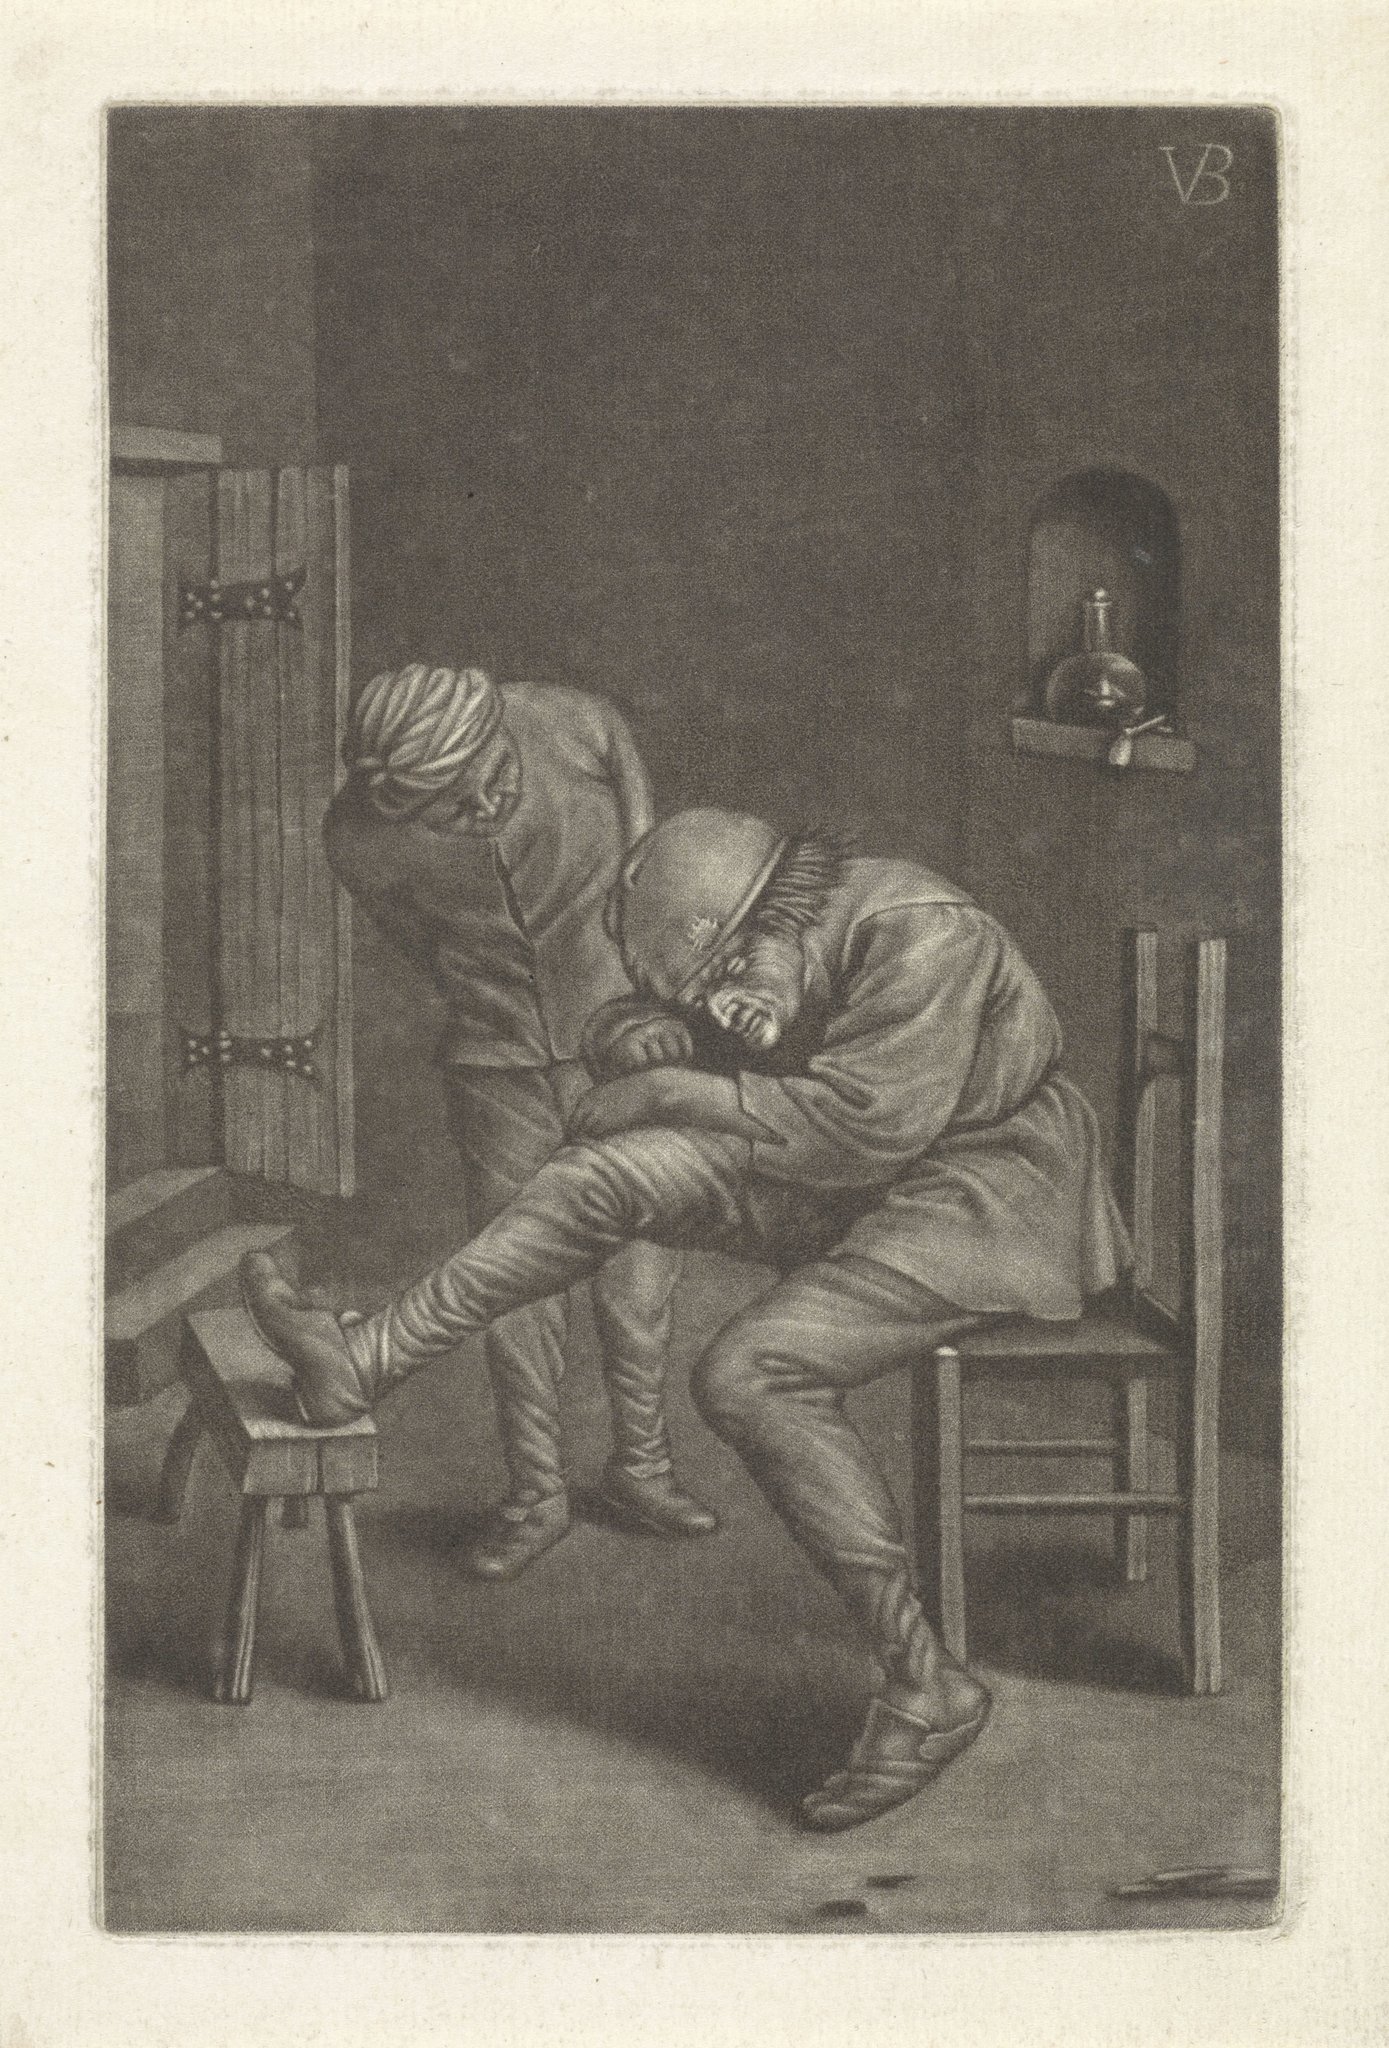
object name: print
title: Slapende man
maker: jan van der bruggen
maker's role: draughtsman, print maker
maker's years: 1649-1709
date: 1659-1740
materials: paper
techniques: mezzotint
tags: sleeping in chair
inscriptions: collector's mark: Lugt 2228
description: Een man bekijkt een andere man die zit te slapen in een stoel.